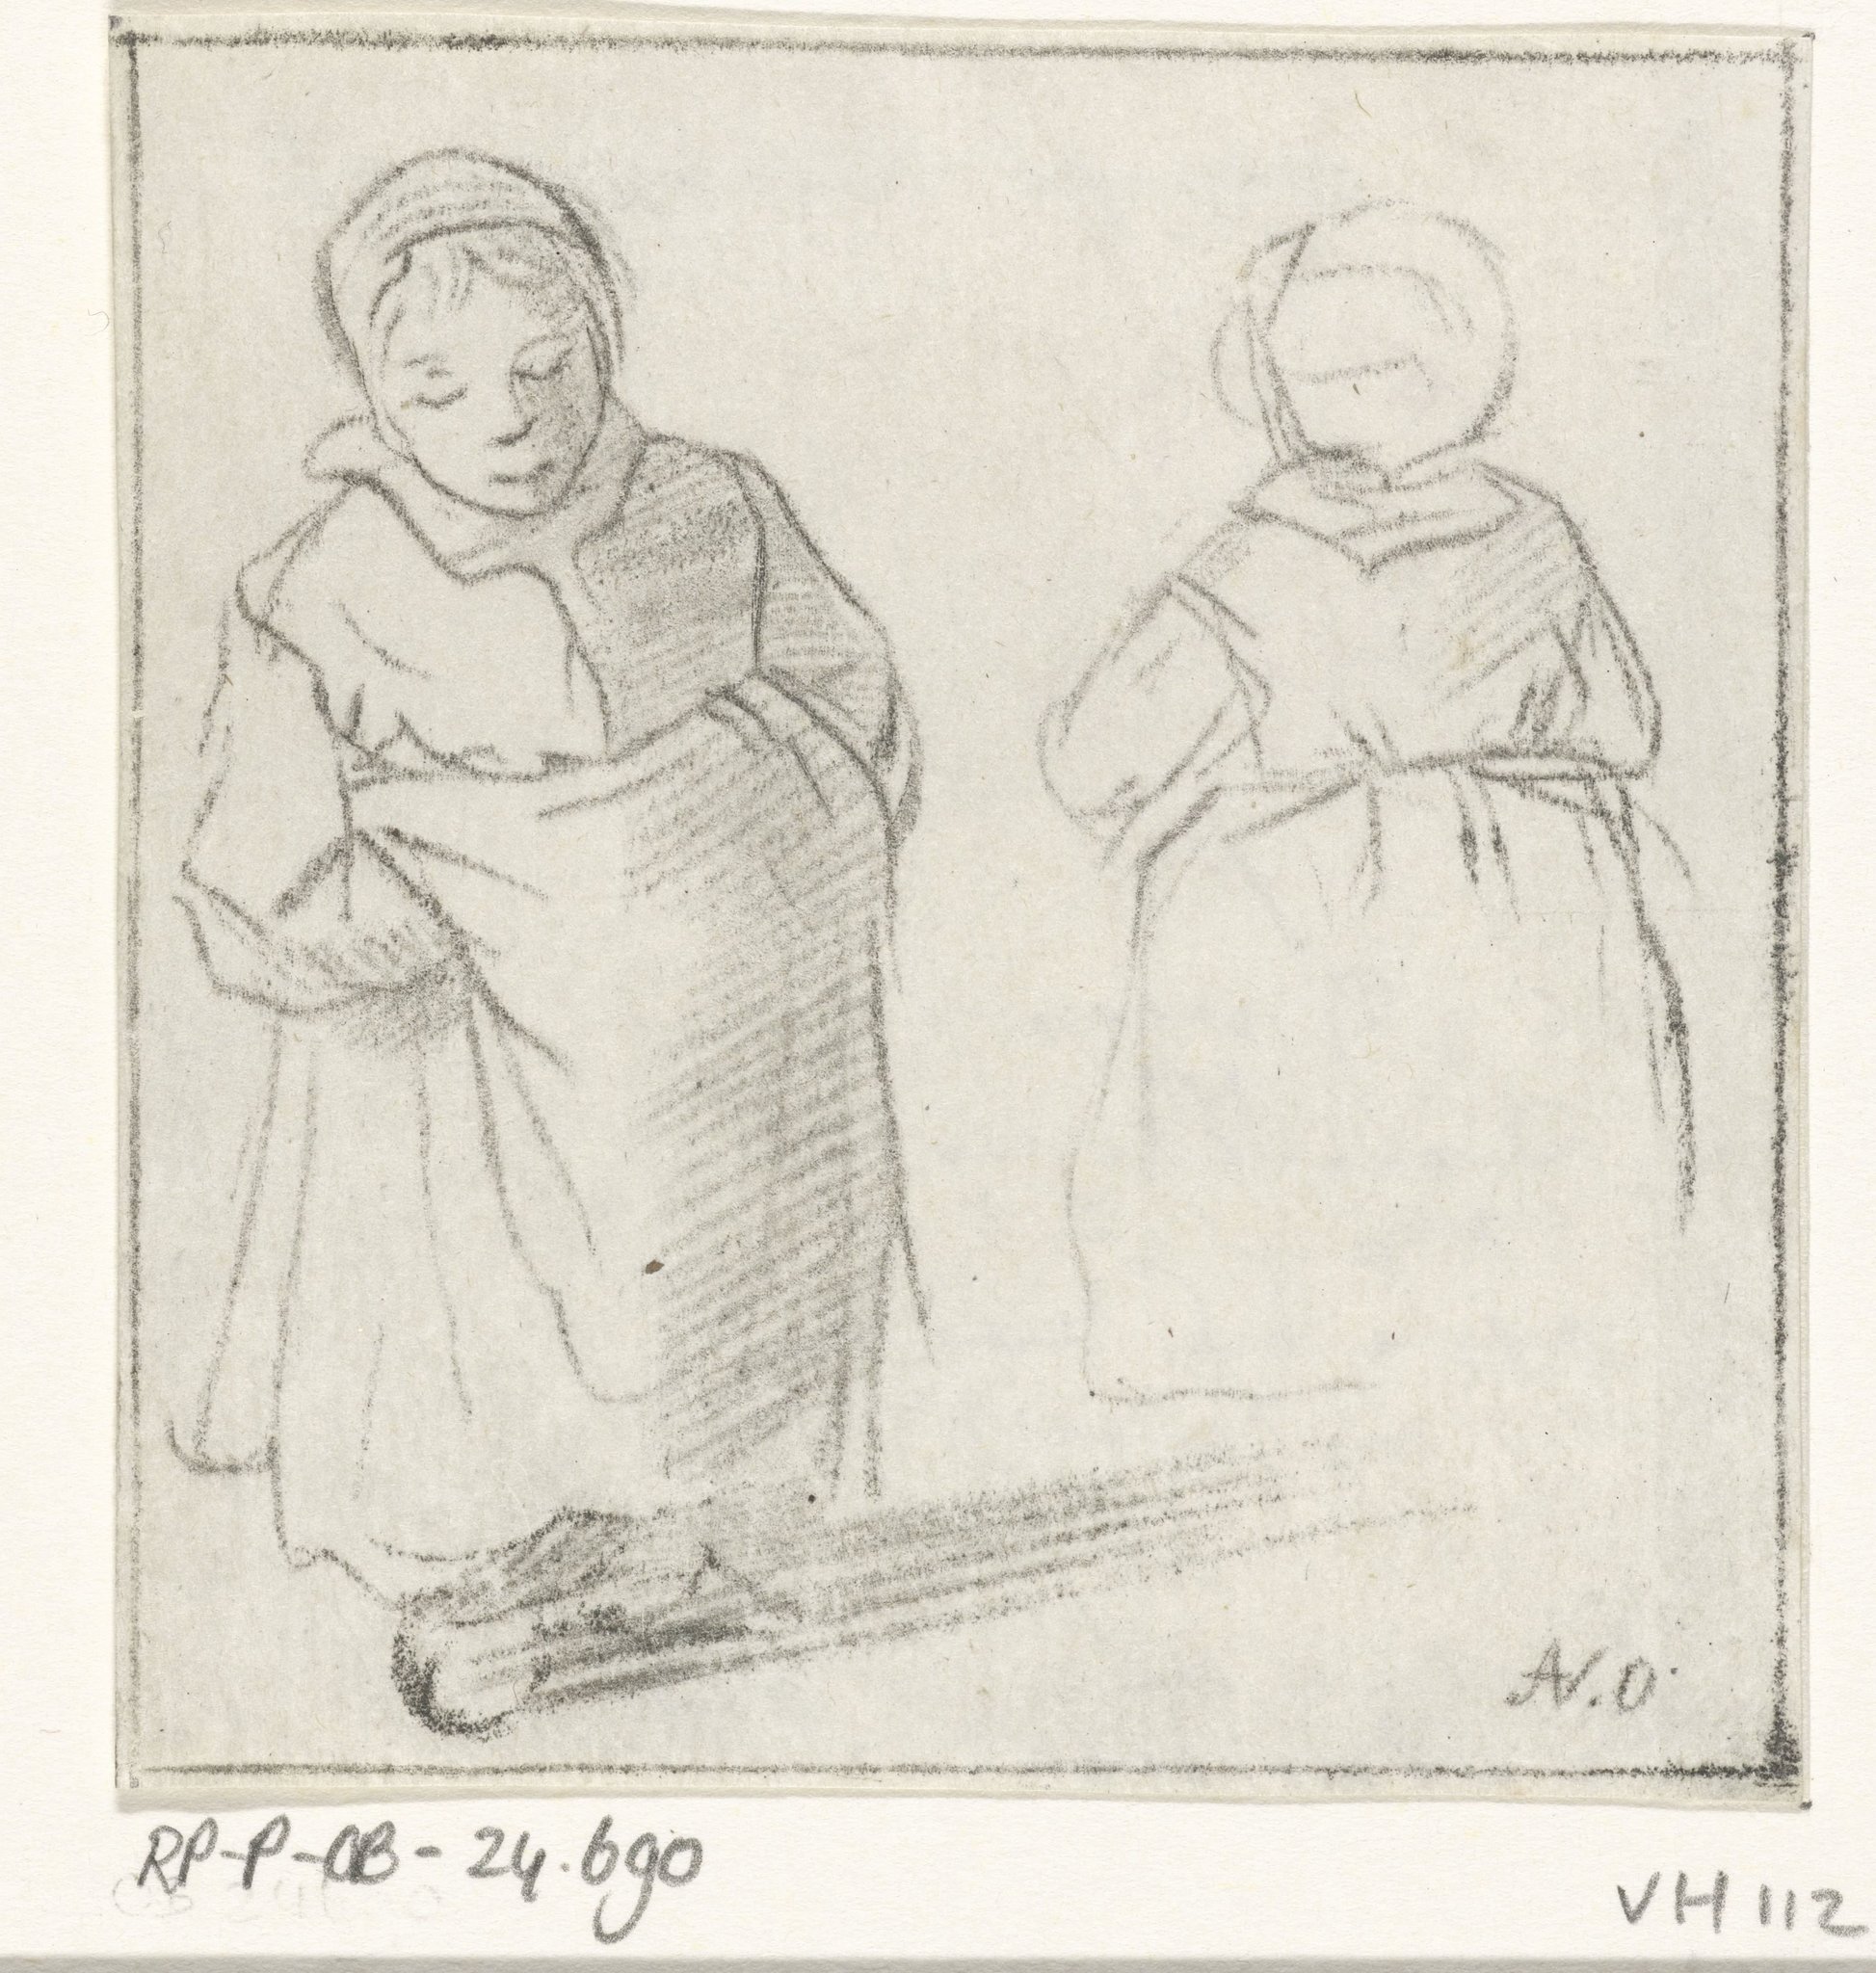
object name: print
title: Twee jonge kinderen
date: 1756-1767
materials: paper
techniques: printmaking, roulette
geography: amsterdam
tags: girl (child between toddler and youth)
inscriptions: collector's mark: Lugt 240, inscription: ‘Geoffreerd aan de heer van [...] op verzoek van vrind Hemsterhuis / A v Ostade del P v Amstel F’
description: Een meisje met de handen onder haar schort. Een ander meisje op de rug gezien.